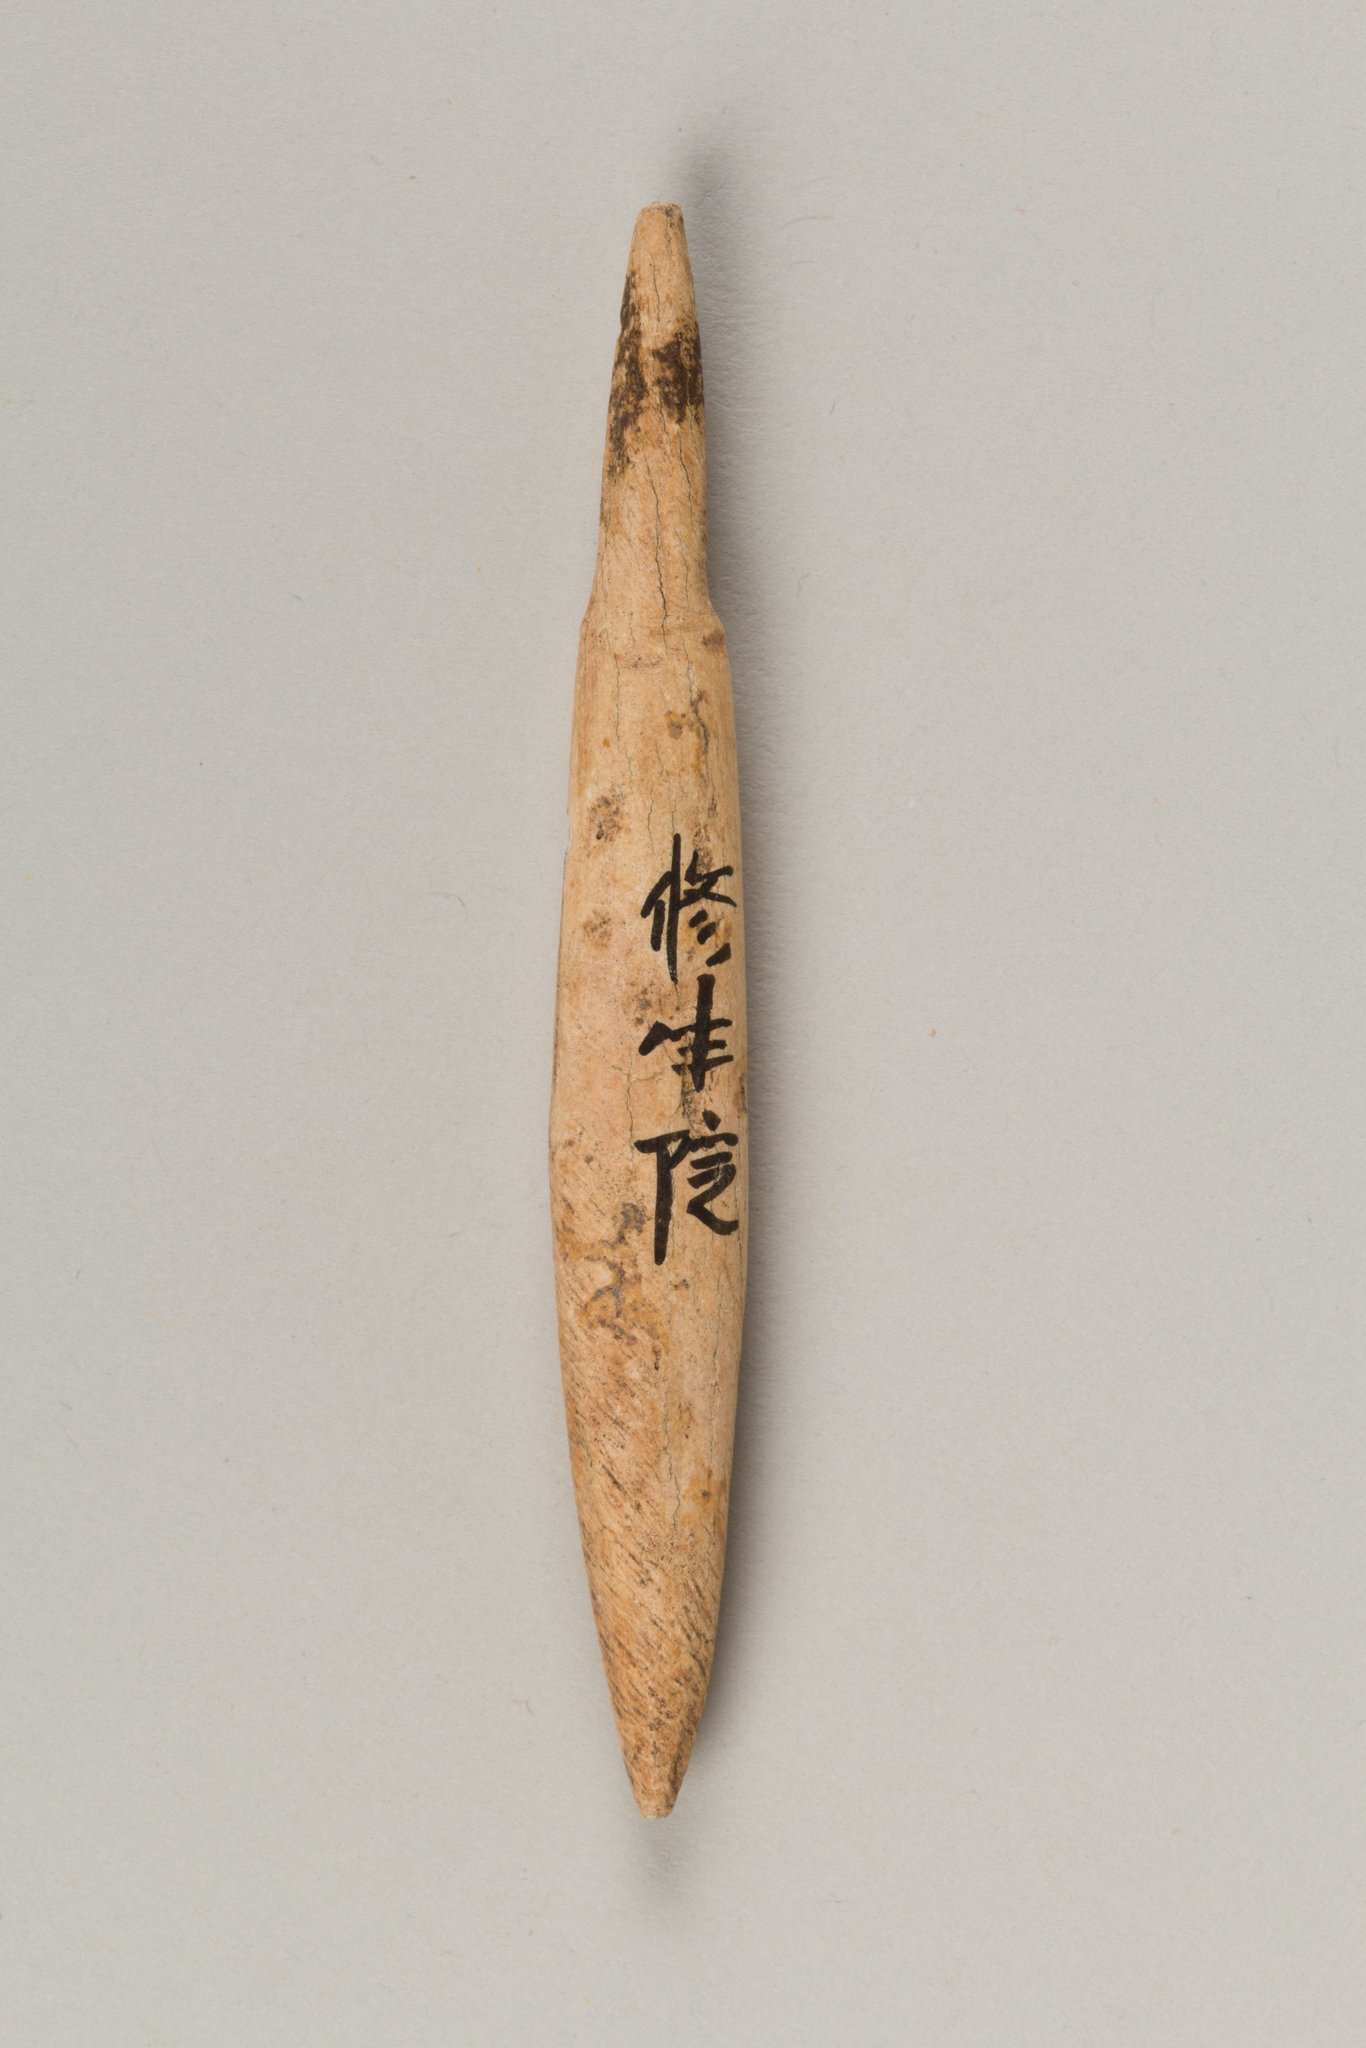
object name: harpoon head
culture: japanese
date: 1000-300 BCE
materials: bone